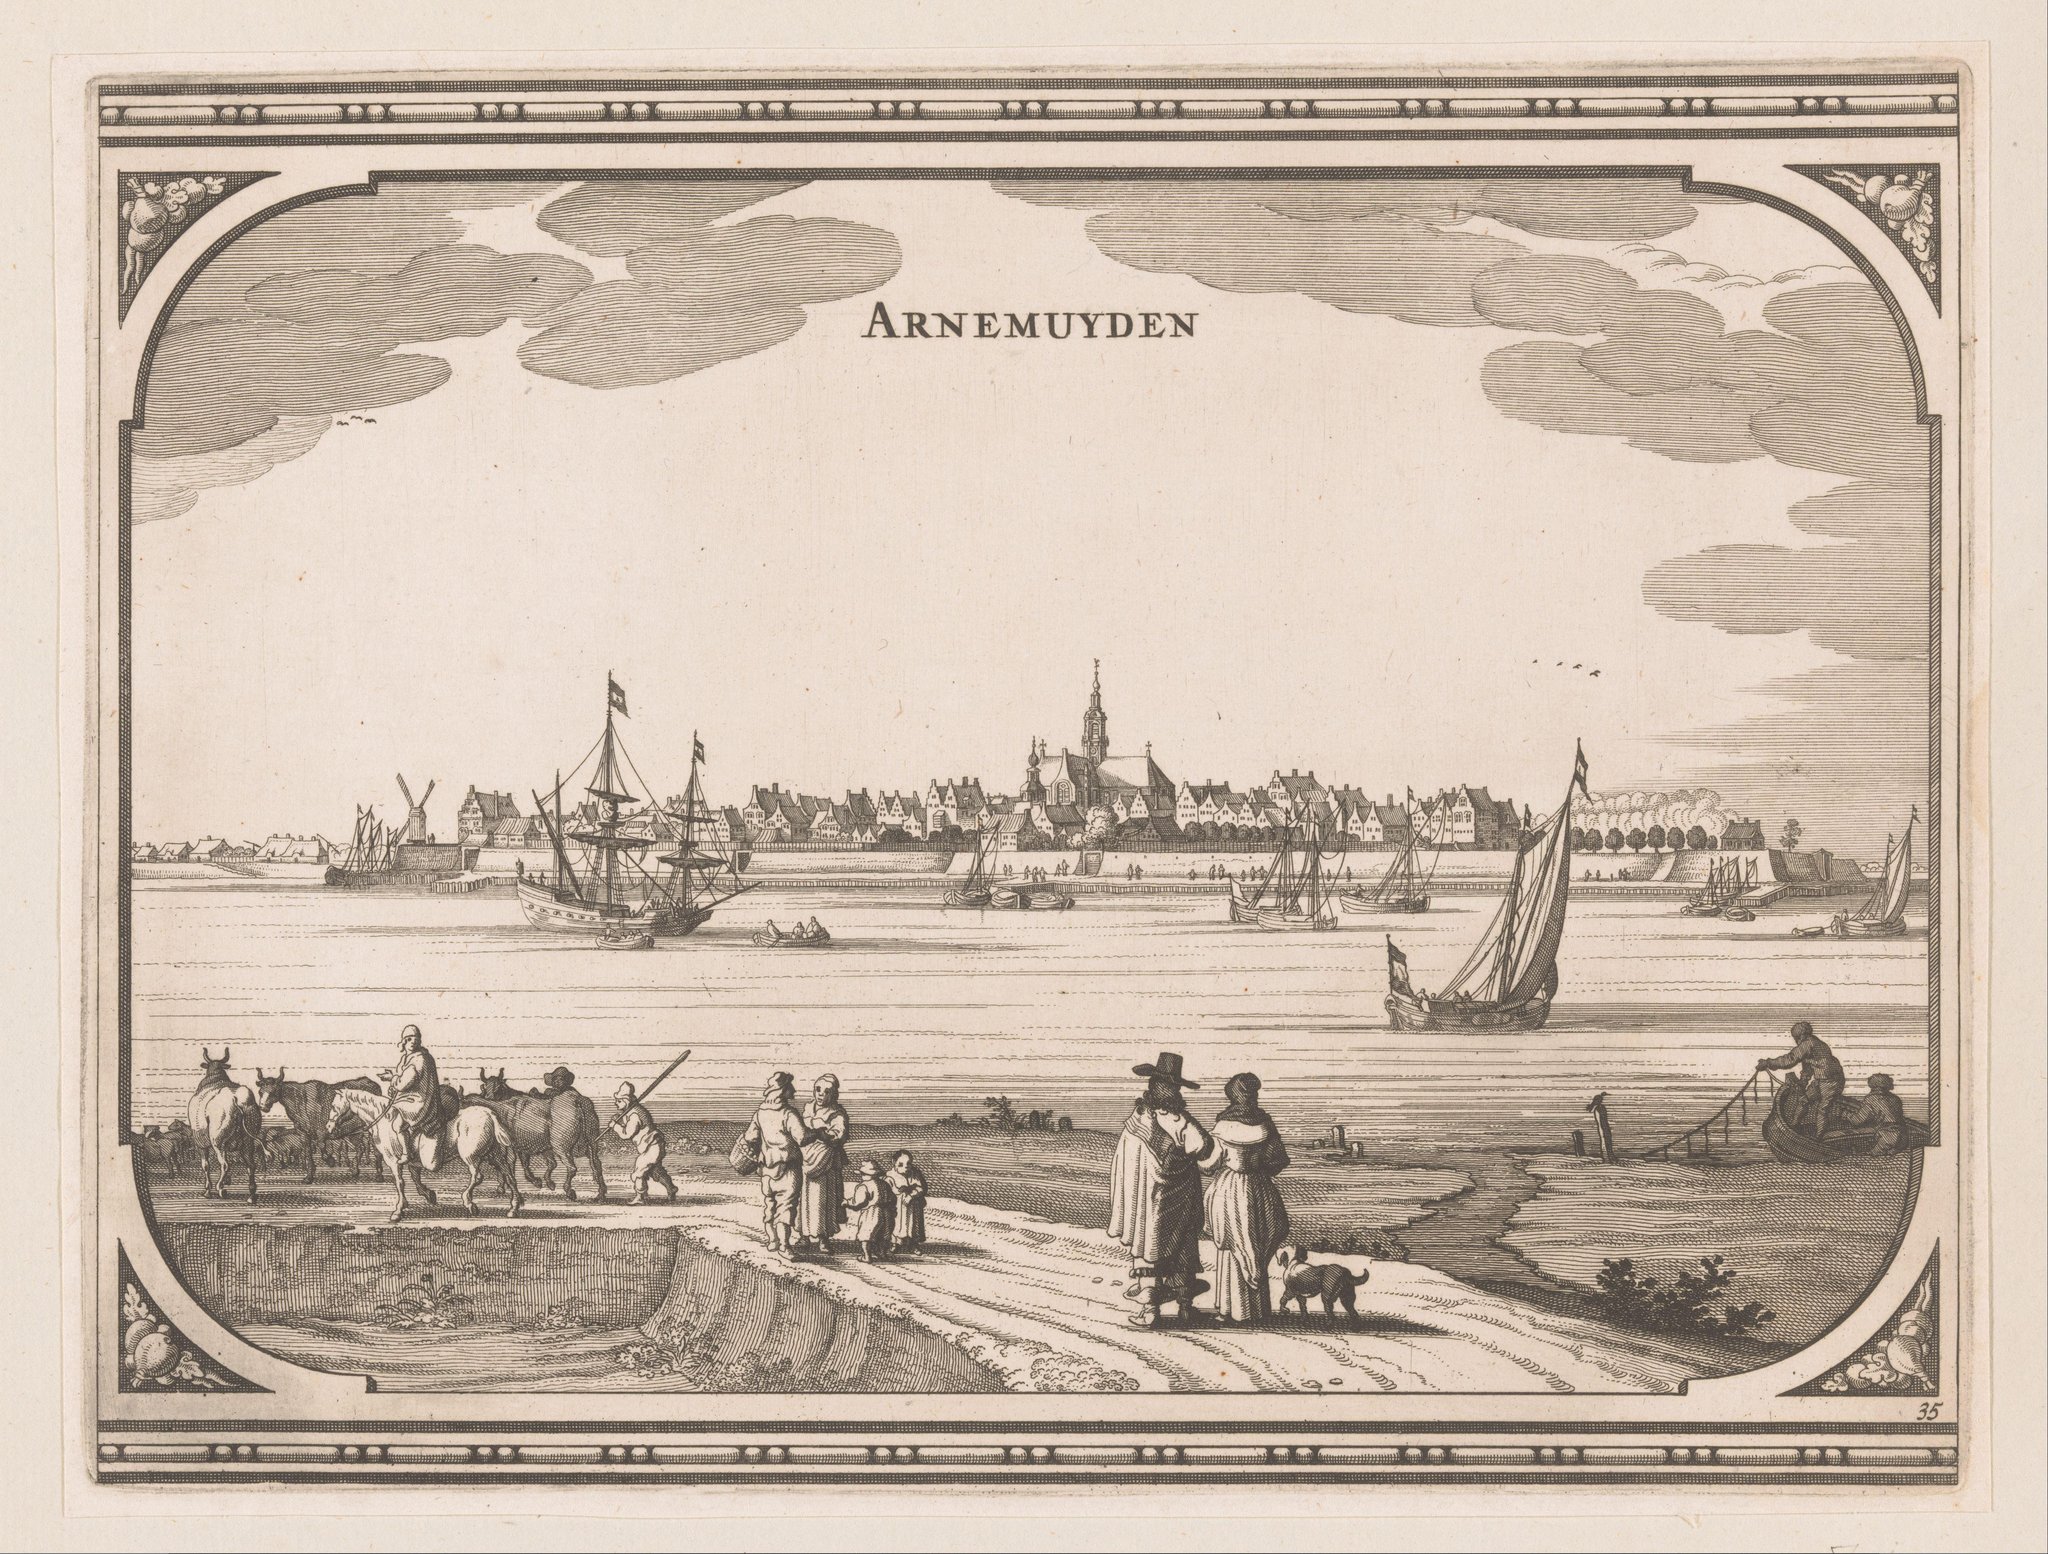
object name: print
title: Gezicht op Arnemuiden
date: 1656-1657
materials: paper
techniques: etching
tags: prospect of village, silhouette of village, pier, quay, wharf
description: Prent verschenen in: Theatrum praecipuarum urbium ducatus Brababtiae necnon comitatum Flandriae et Zelandiae. Amsterdam: Nicolaes Visscher, 1657. En in: Schut, Pieter Hendricksz.Theatrum praecipuarum urbium ducatus Brababtiae necnon comitatum Flandriae et Zelandiae. Amsterdam: Nicolaes Visscher, 1657. En in: Caerten en Steden van Brabant, Vlaenderen ende Zeelandt, Middelburg. Middelburg: Zacharias Roman, Amsterdam: Nicolaes Visscher, 1656. Verschillende staten van prenten zijn gebruikt in uitgaven van 'Speculum Zelandiae' en in andere publicaties uitgegeven door Zacharias Roman en Nicolaes Visscher (I). Verwarring rondom de datering kan ontstaan door het feit dat de prenten uit 'Speculum Zelandiae' ook voorkomen in eerder uitgegeven publicaties, waar ze later in zijn ingebonden. Zo komen prenten uitgegeven door Roman/Visscher voor in sommige exemplaren van: Boxhorn, Marcus Zuerius van. Chroniick van Zeelandt (…). 2 dln. Middelburg: Zacharias Roman, 1644. De door weduwe (Joachim) Ottens en Zoonen uitgegeven prenten zijn later ingebonden in sommige exemplaren van: Smallegange, Mattheus. Nieuwe Cronyk van Zeeland (…). Middelburg en Amsterdam: Johannes Meertens en Abraham van Someren, 1696.